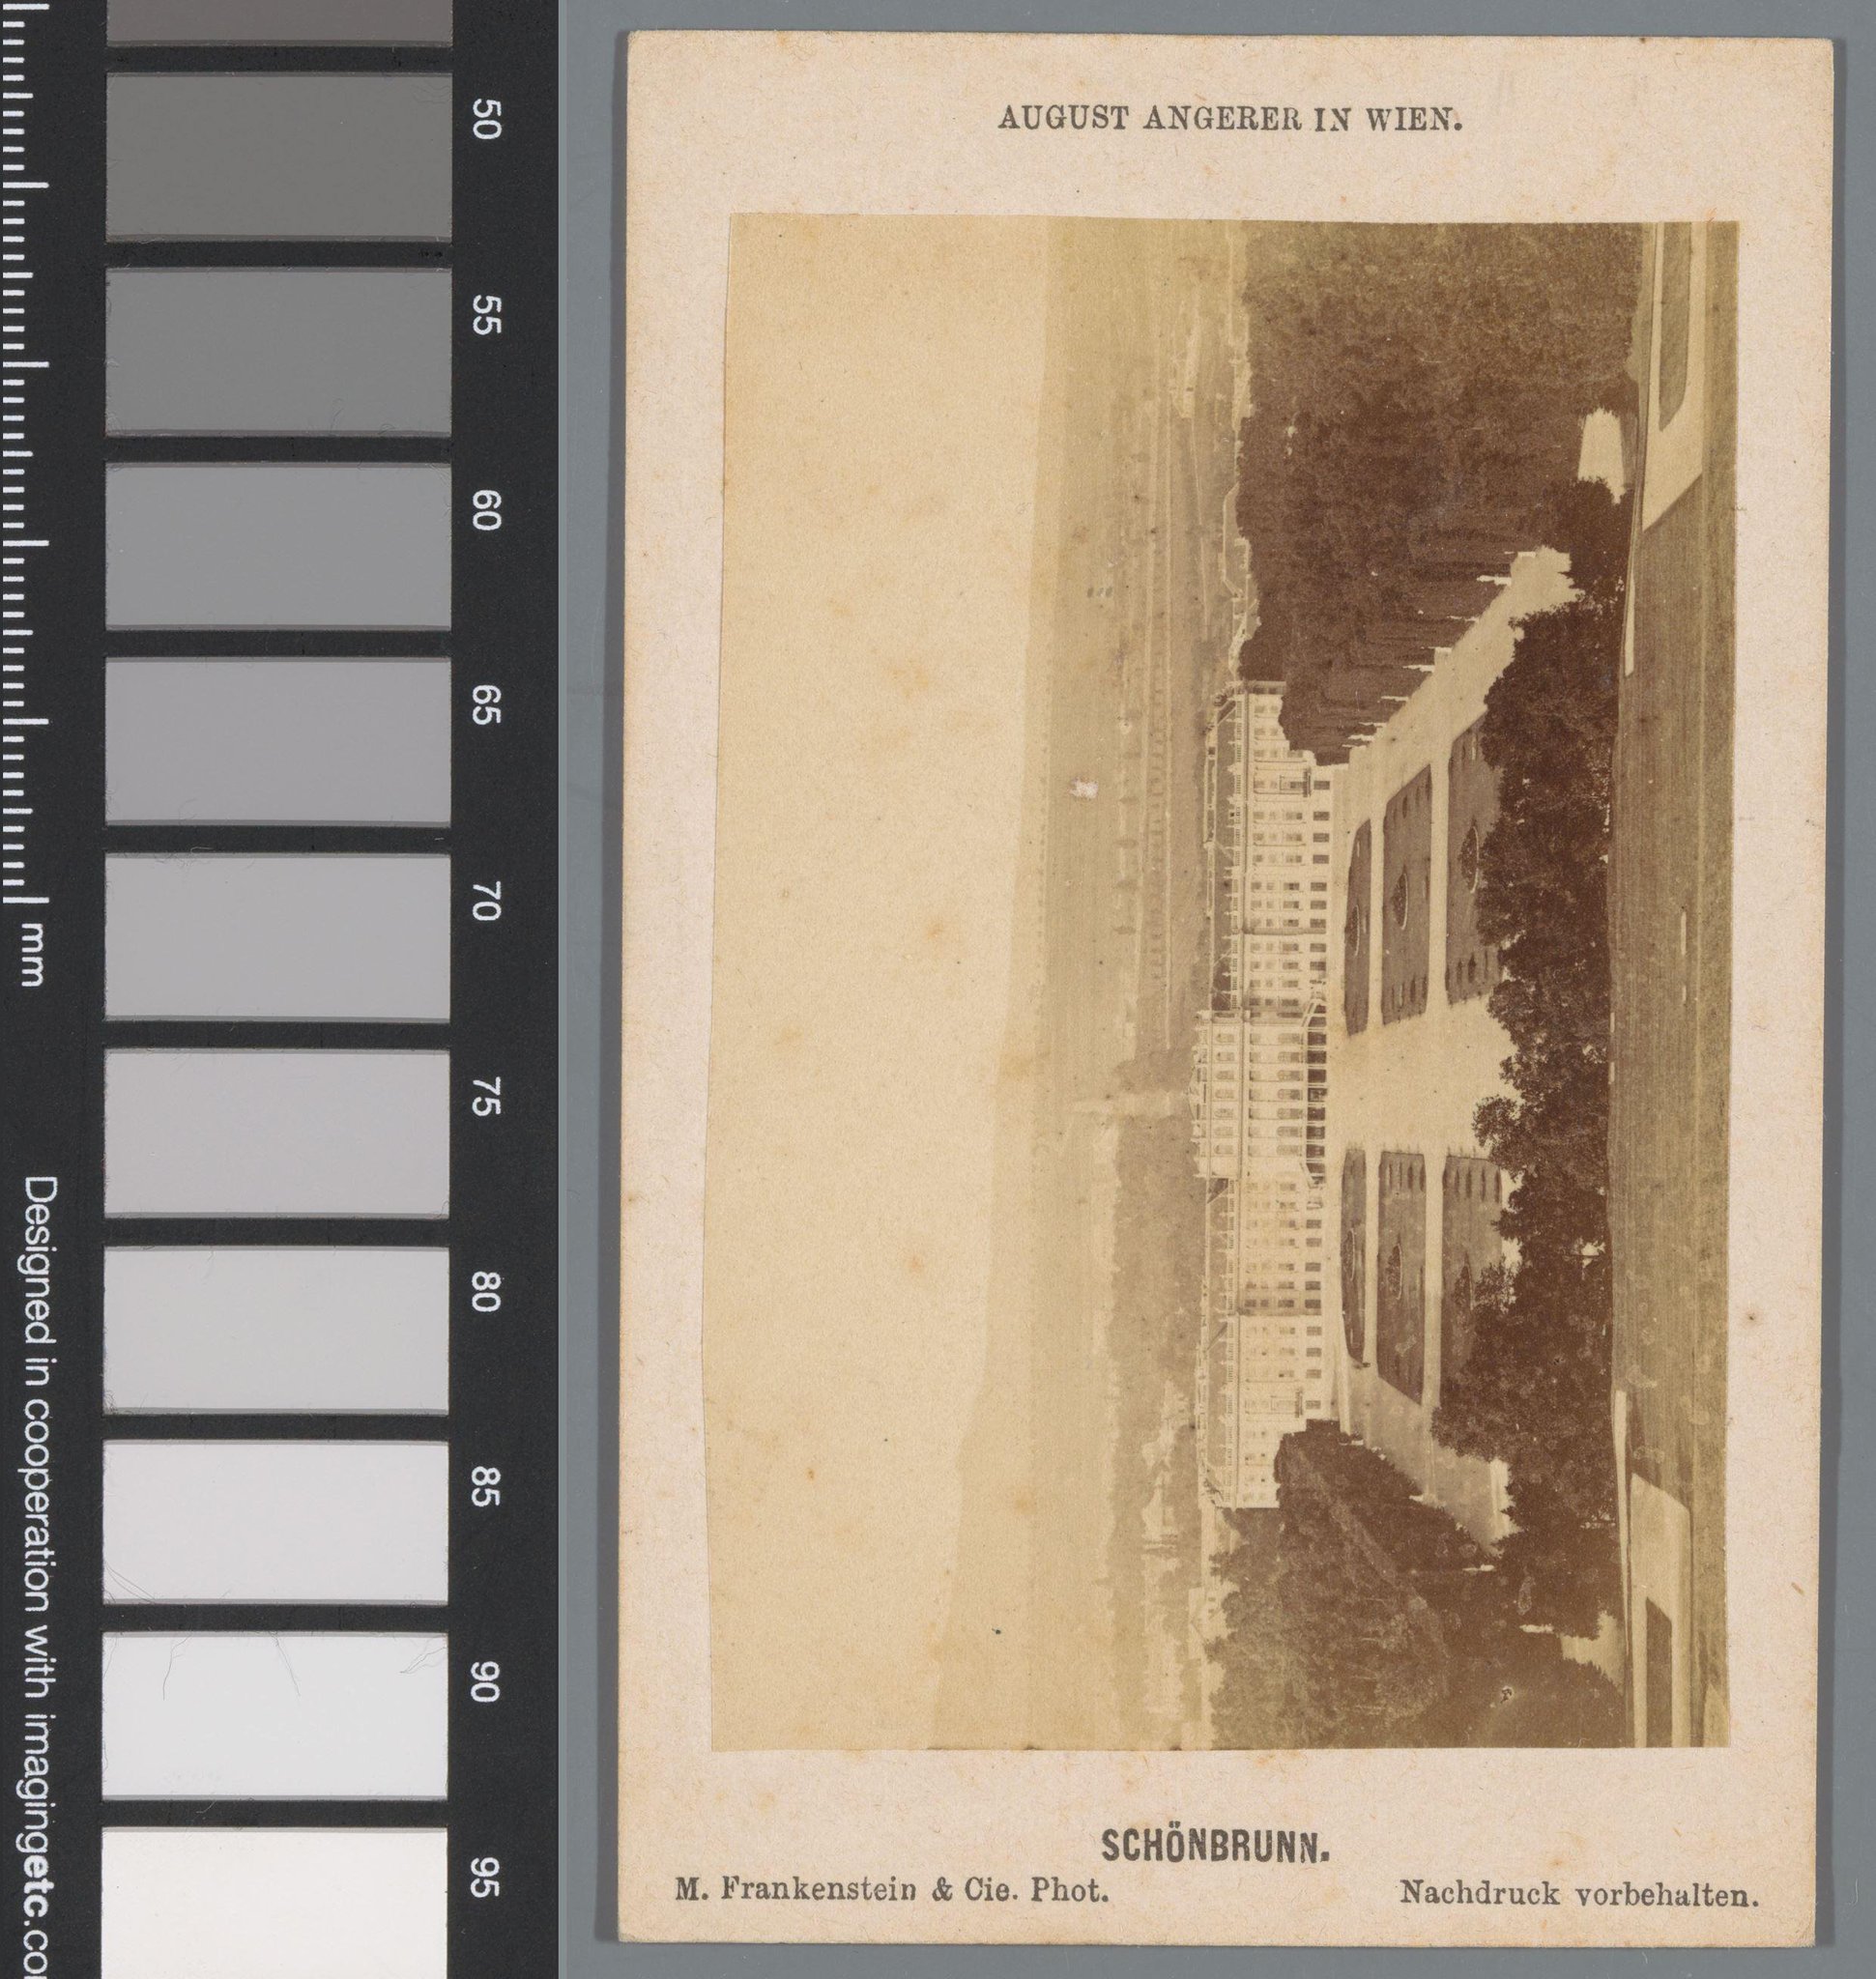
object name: carte de visite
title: Schönbrunn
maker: august angerer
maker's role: publisher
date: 1868-1880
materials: cardboard, paper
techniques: albumen print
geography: vienna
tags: palace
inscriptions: inscription: ‘Nachdruck vorbehalten.’